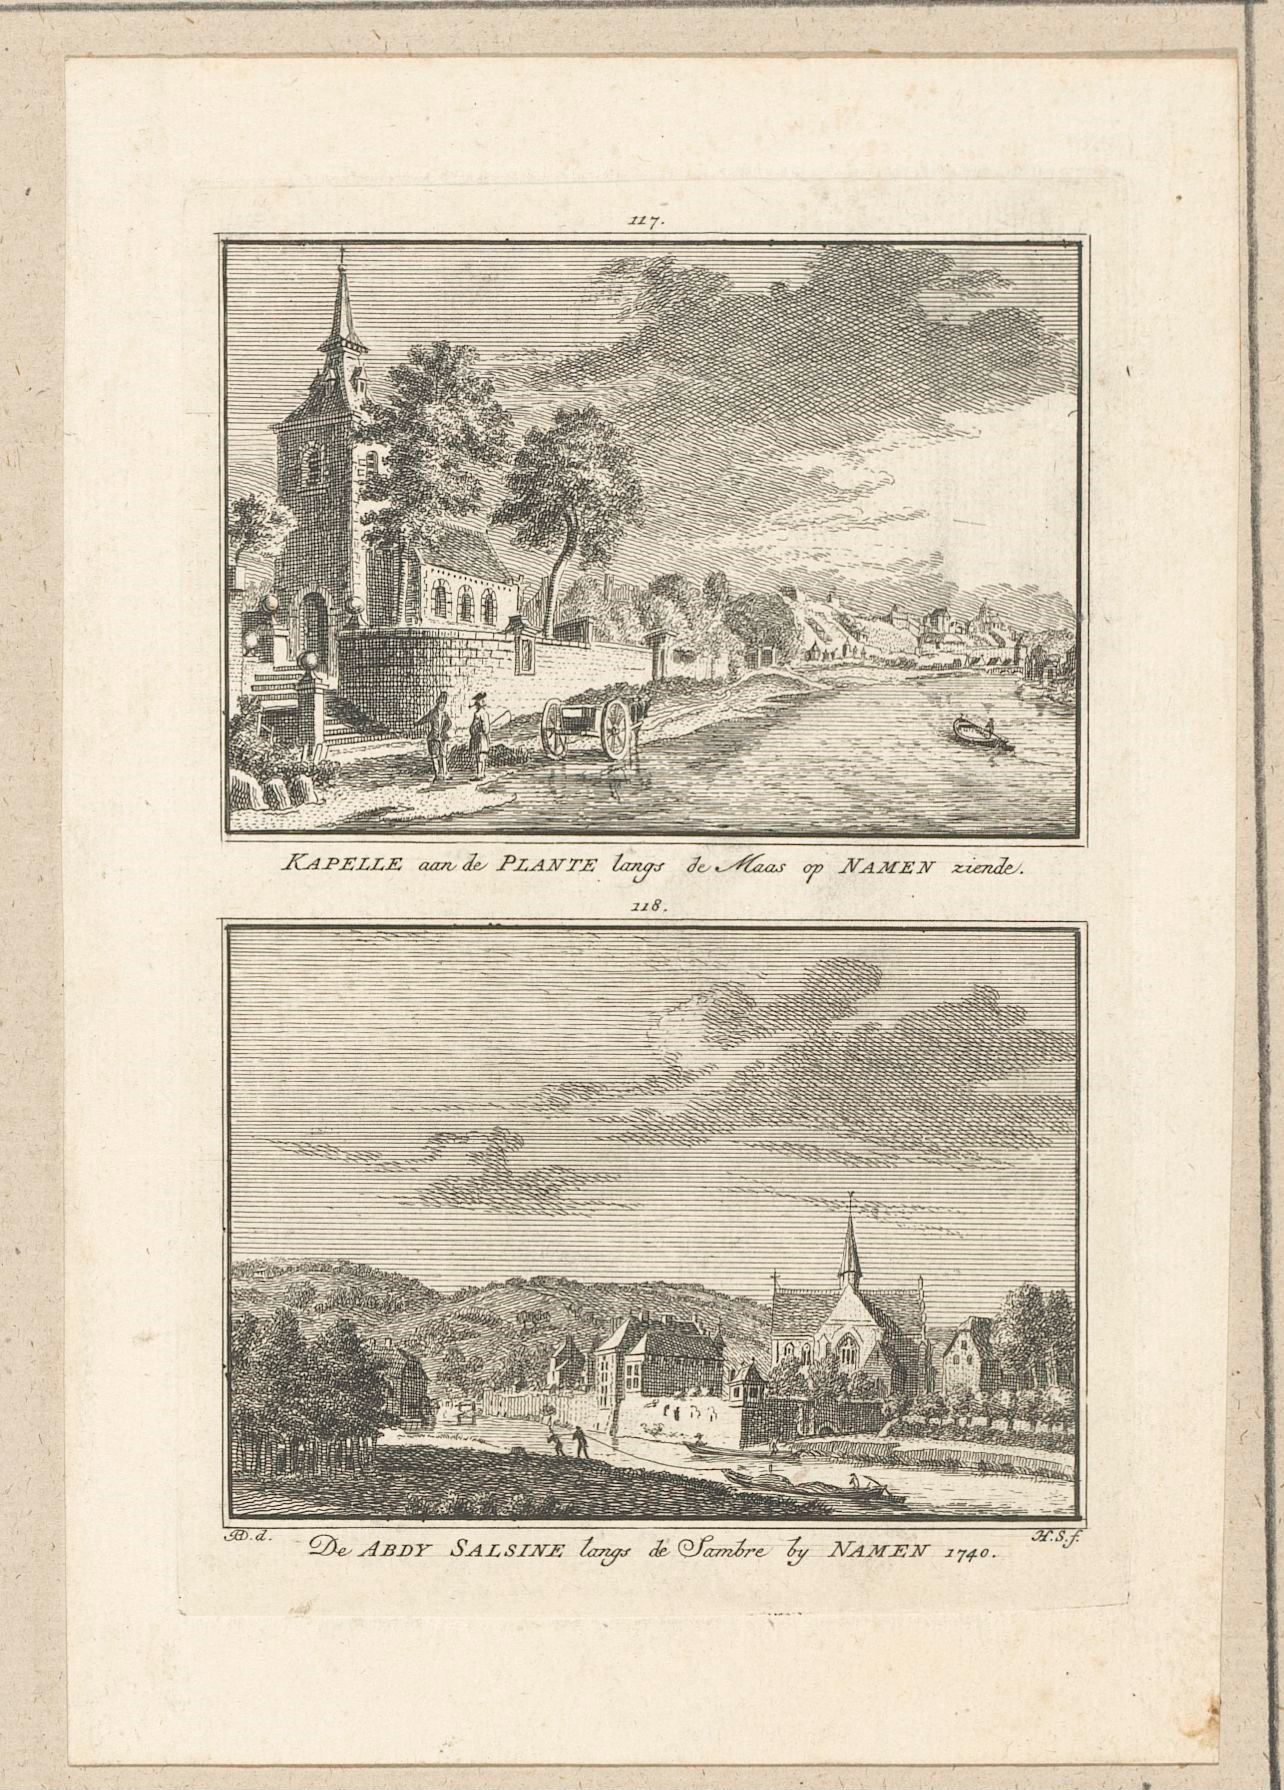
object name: print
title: Kapelle aan de Plante langs de Maas op Namen ziende / De abdy Salsine langs de Sambre by Namen 1740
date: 1746-1792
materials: paper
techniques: engraving, etching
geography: haarlem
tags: abbey, monastery, convent ~ roman catholic church, church (exterior) - qq - small church, chapel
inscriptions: collector's mark: Lugt 2228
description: Prent ook gebruikt in: Het verheerlykt Nederland of kabinet van hedendaagsche gezigten van steden, dorpen (…). 9 delen. Amsterdam: Isaak Tirion en weduwe Isaak Tirion, 1745-1774, dl. 2 (1746), ill. 117-118. Of in: Nederlandsche tafereelen; of eene keurige verzameling van negen honderd fraaije gezigten van steden, dorpen, sloten, oudheden (…). 9 delen. Amsterdam: Jan de Groot, 1792, dl. 2, ill. 117-118.